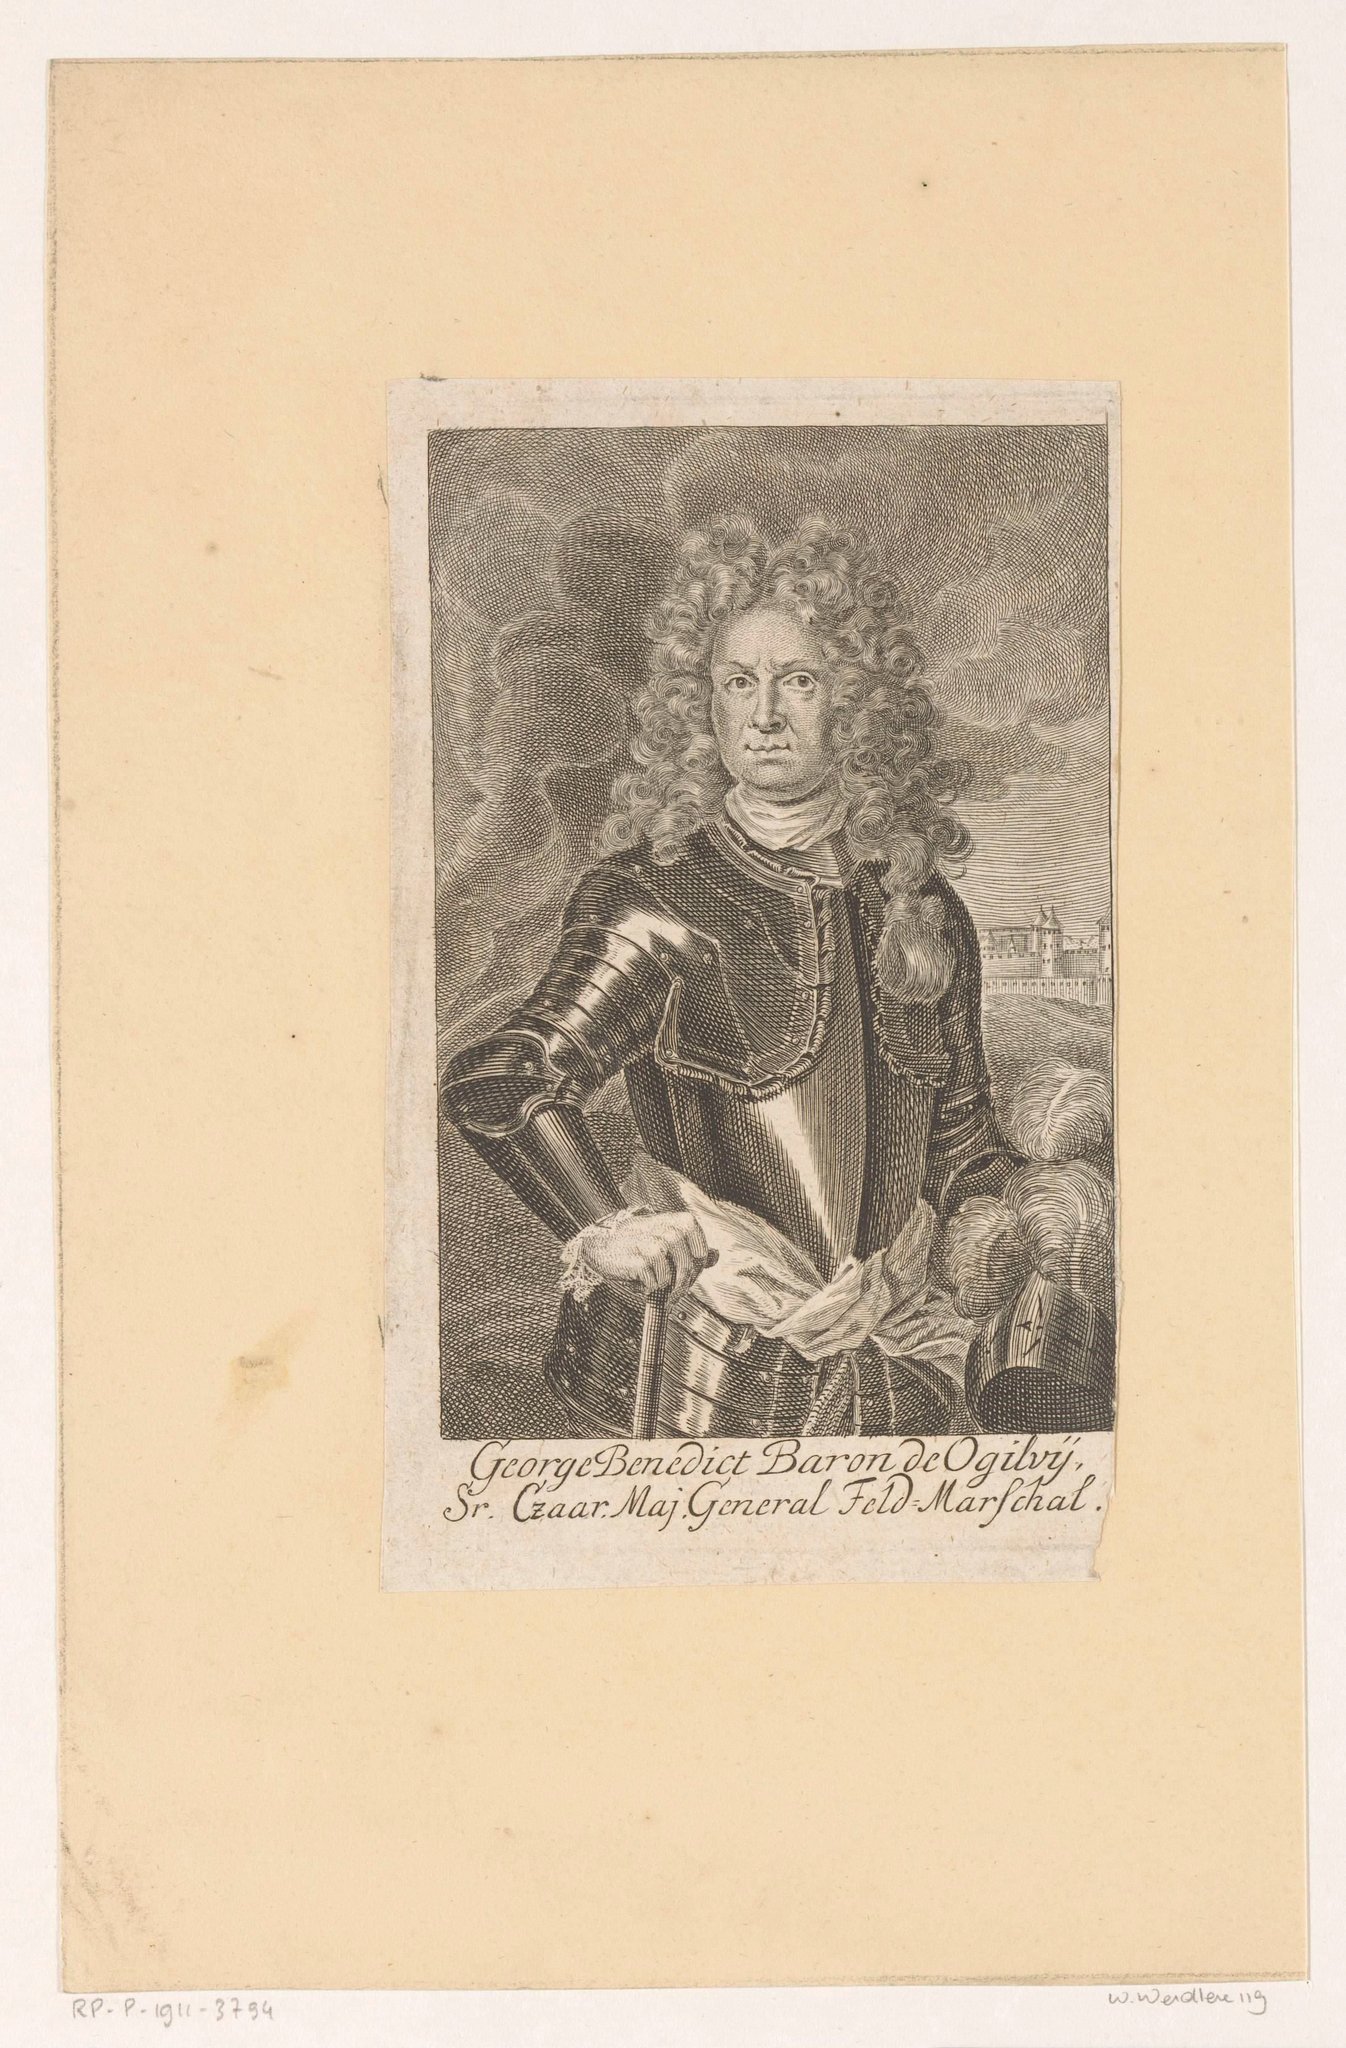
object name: print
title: Portret van Georg Benedict Freiherr von Ogilvy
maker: martin bernigeroth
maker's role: print maker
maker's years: 1670-1733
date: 1705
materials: paper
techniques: engraving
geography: leipzig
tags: castle, armour, historical persons, baton of general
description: Prent ook gebruikt in: Die Europäische Fama, Welche den gegenwärtigen Zustand der vornehmsten Höfe entdecket. dl. 41. Leipzig: Gleditsch, 1705.